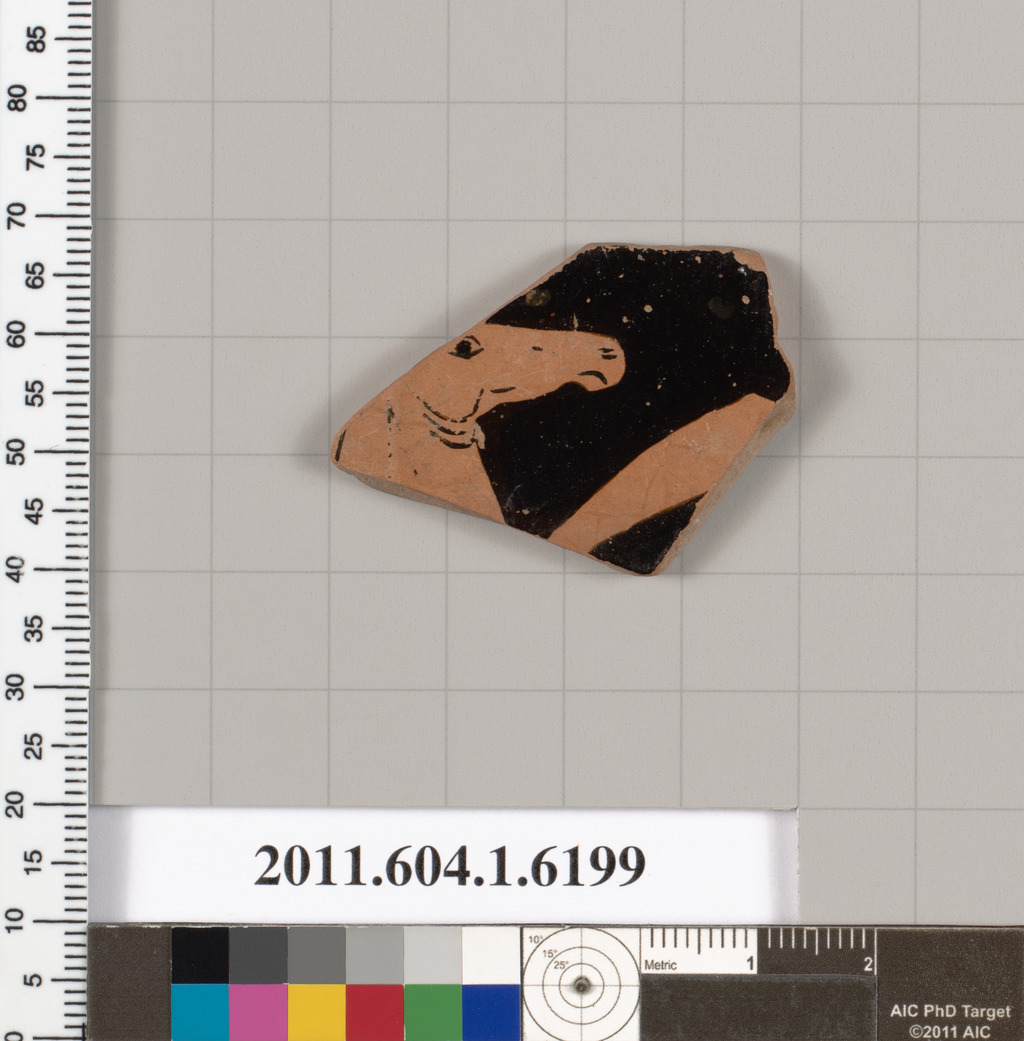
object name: kylix fragment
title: Terracotta rim fragment of a kylix (drinking cup)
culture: greek, attic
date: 510-500 BCE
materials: terracotta